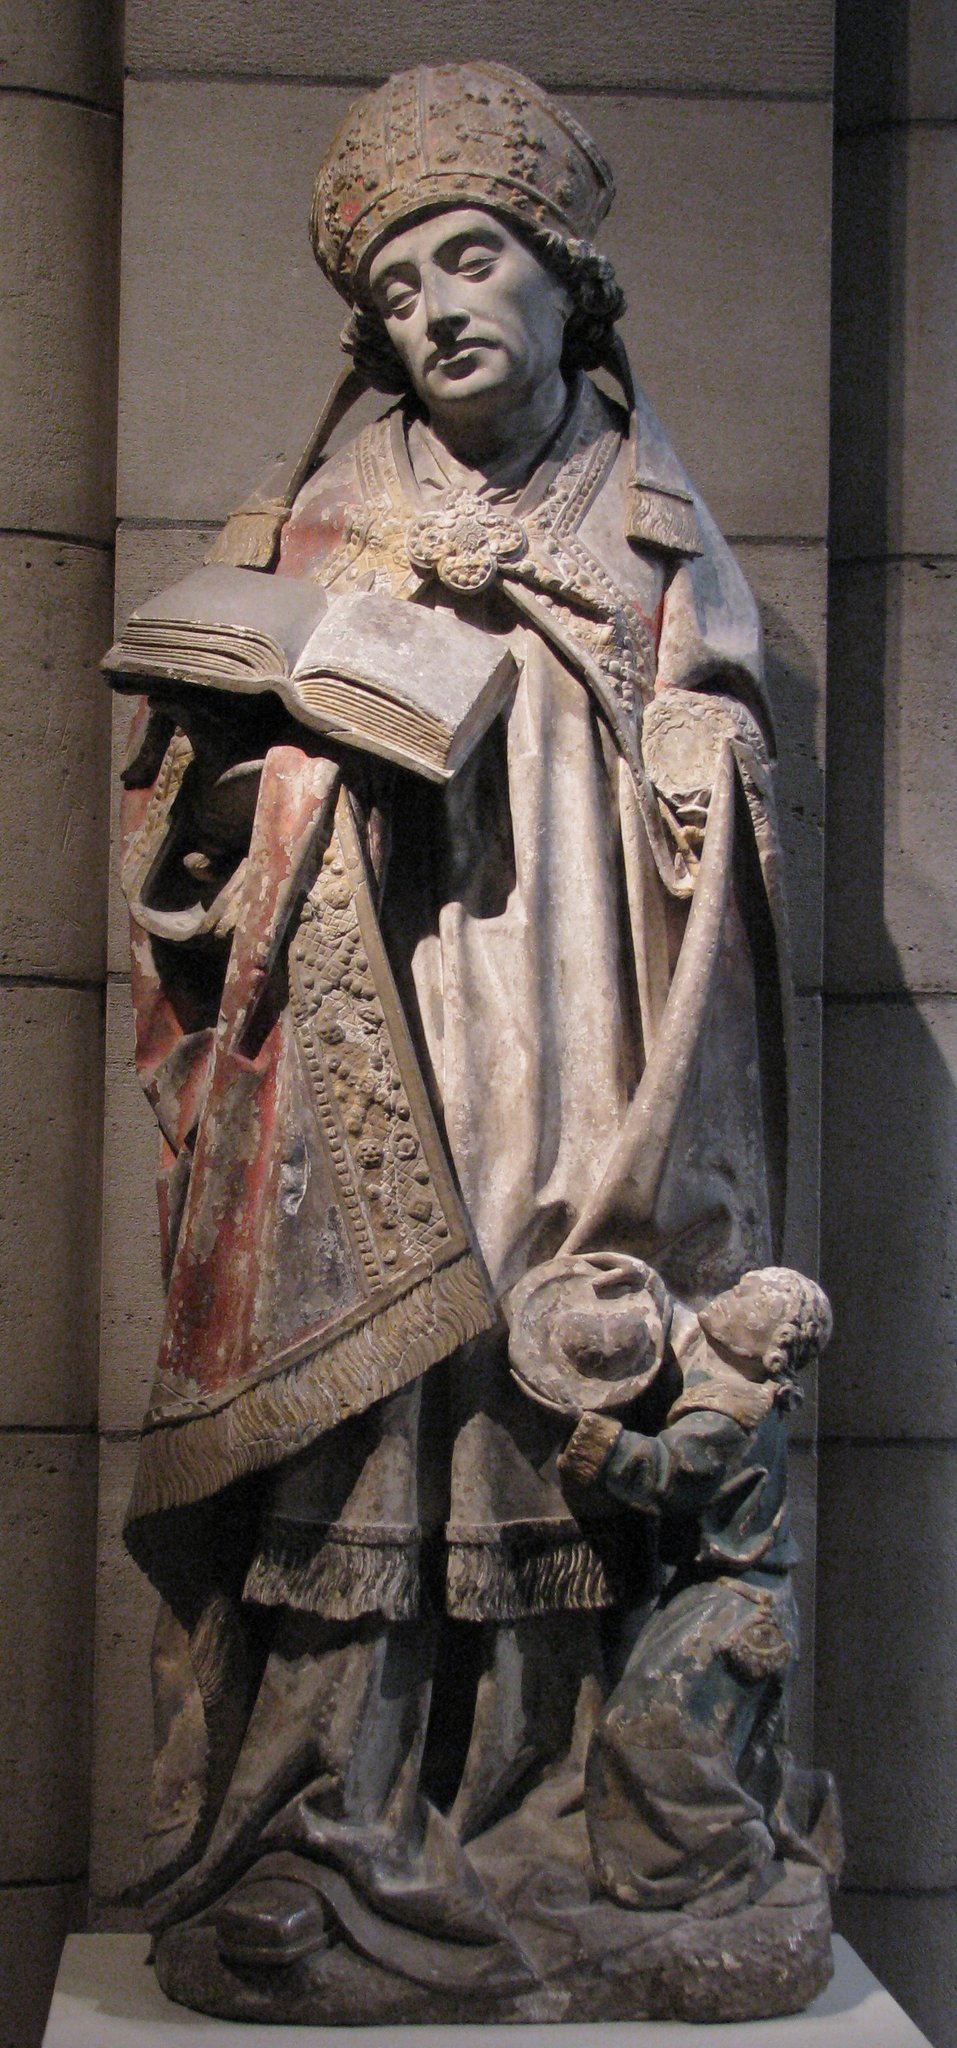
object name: statue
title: Saint Augustine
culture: french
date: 1450-1475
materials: gilt, limestone, paint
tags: men